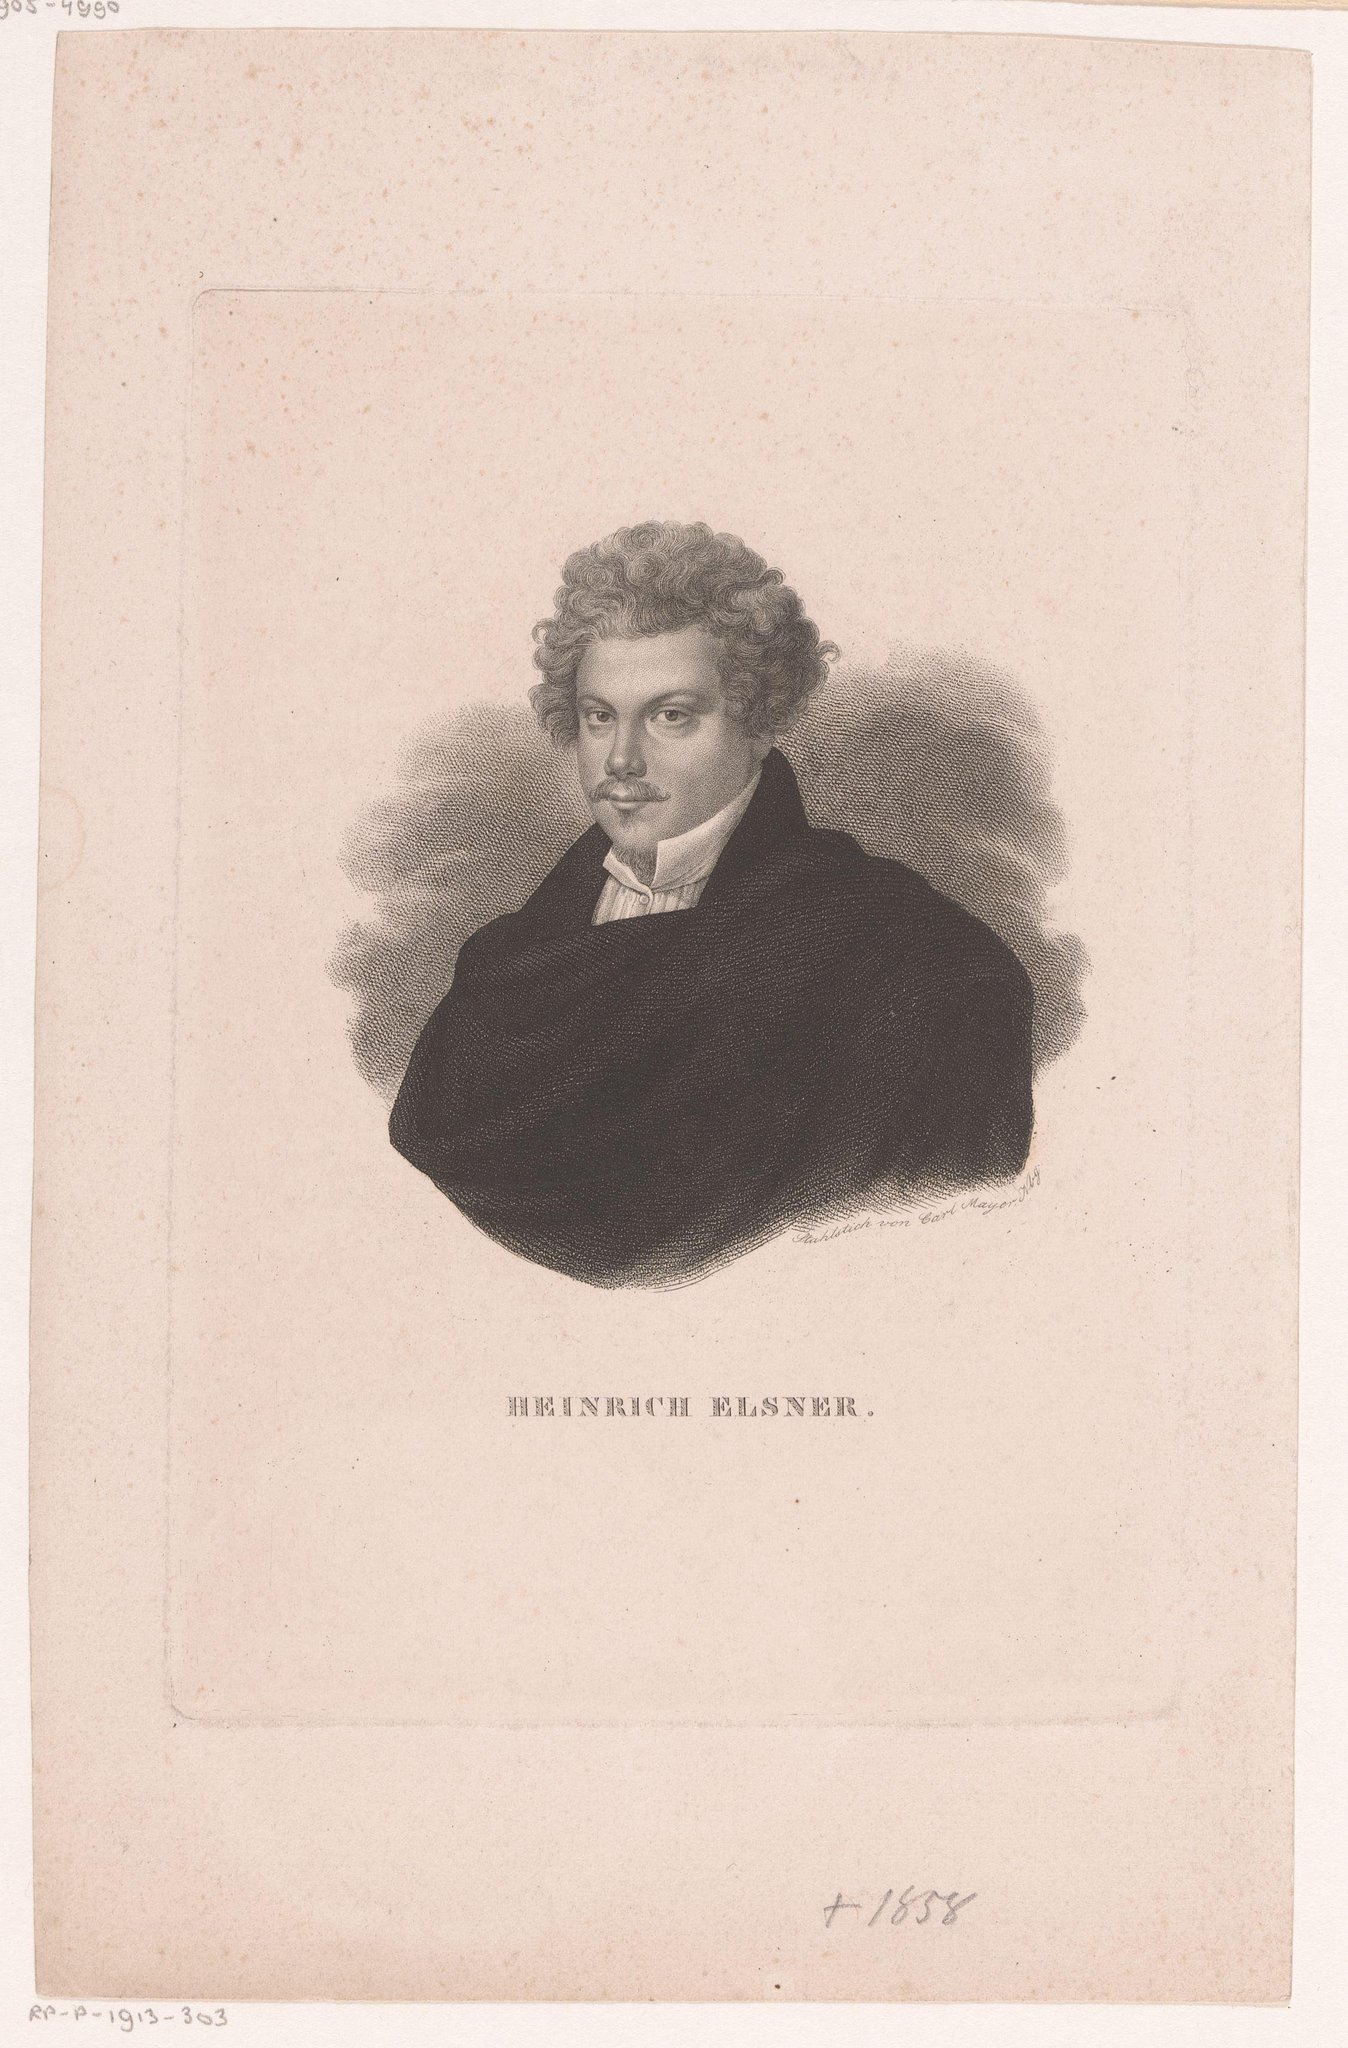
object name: print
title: Portret van Heinrich Elsner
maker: carl mayer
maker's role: print maker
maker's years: 1798-1868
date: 1808-1868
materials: paper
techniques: engraving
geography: nuremberg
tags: historical persons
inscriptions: collector's mark: Lugt 2228